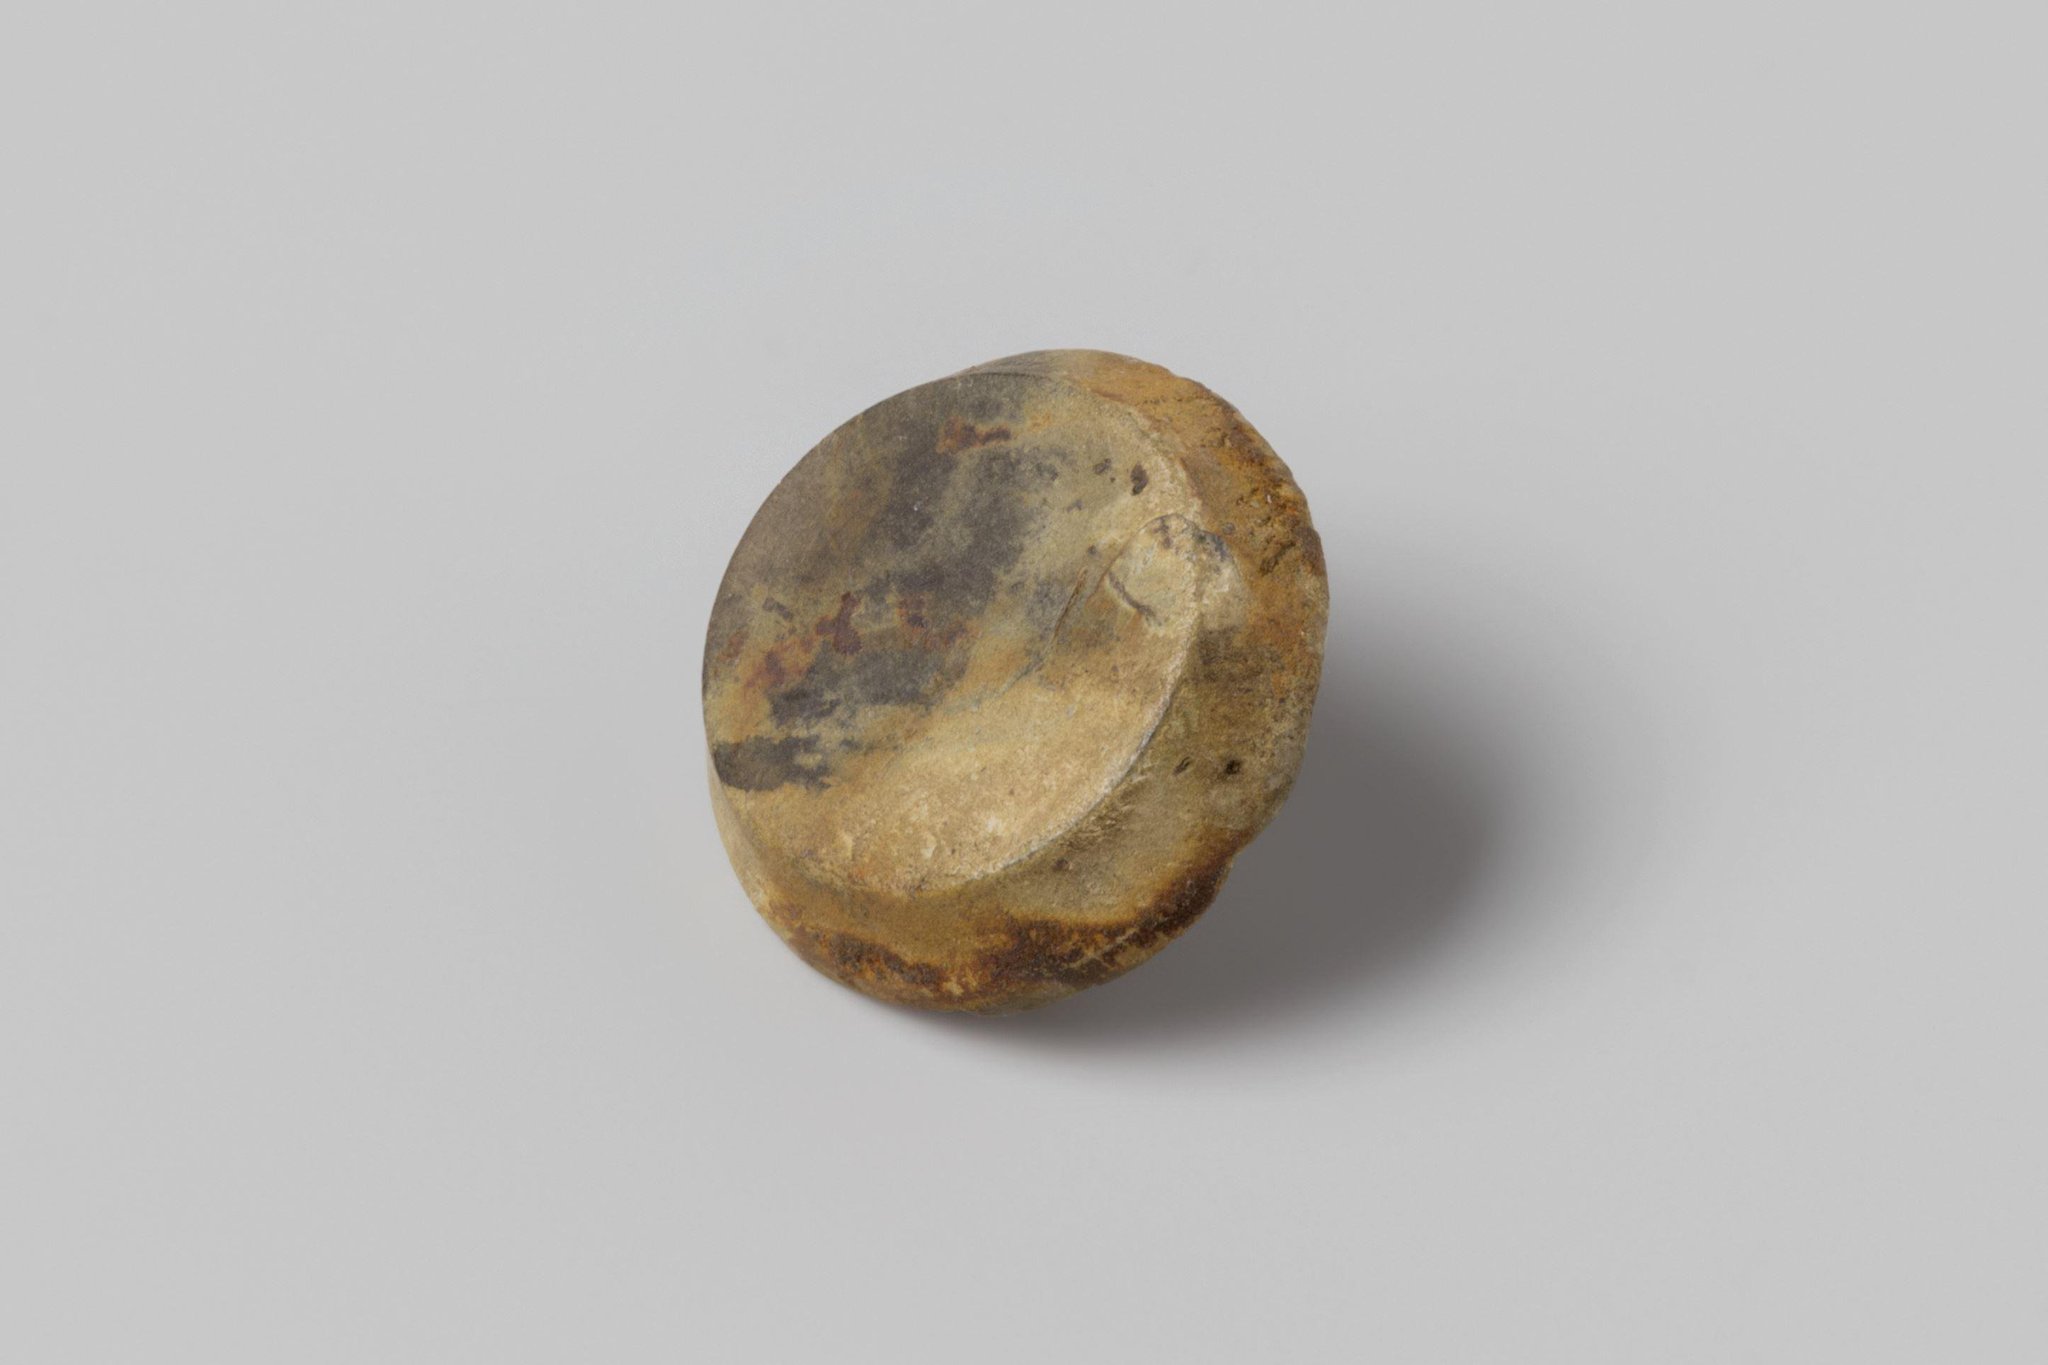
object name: button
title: Knoop uit het wrak van de Oost-Indiëvaarder Hollandia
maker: Anonymous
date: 1700-1743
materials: bone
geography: netherlands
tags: verenigde oostindische compagnie, hollandia (schip), annet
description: Knoop. (1) flat, bevelled rim, plain (1.4d, 0.3t)